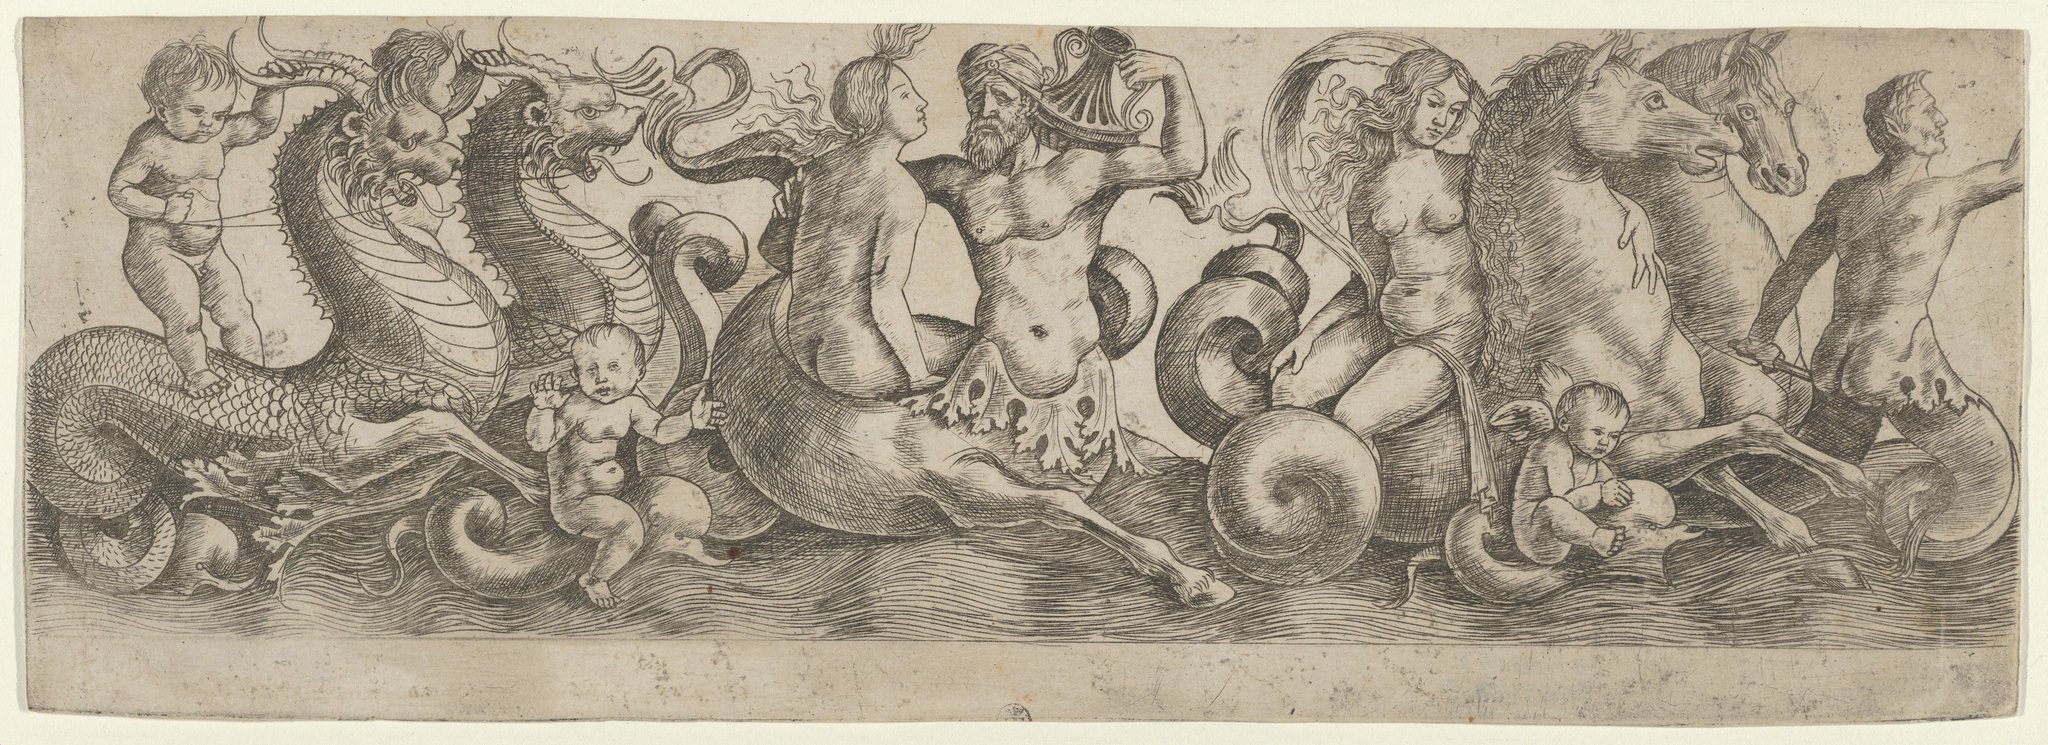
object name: print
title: Frieze with Tritons and Nymphs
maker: girolamo mocetto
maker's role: artist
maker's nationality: italian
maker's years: 1470-1531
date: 1490-1530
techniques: engraving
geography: venice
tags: nymphs,satyrs